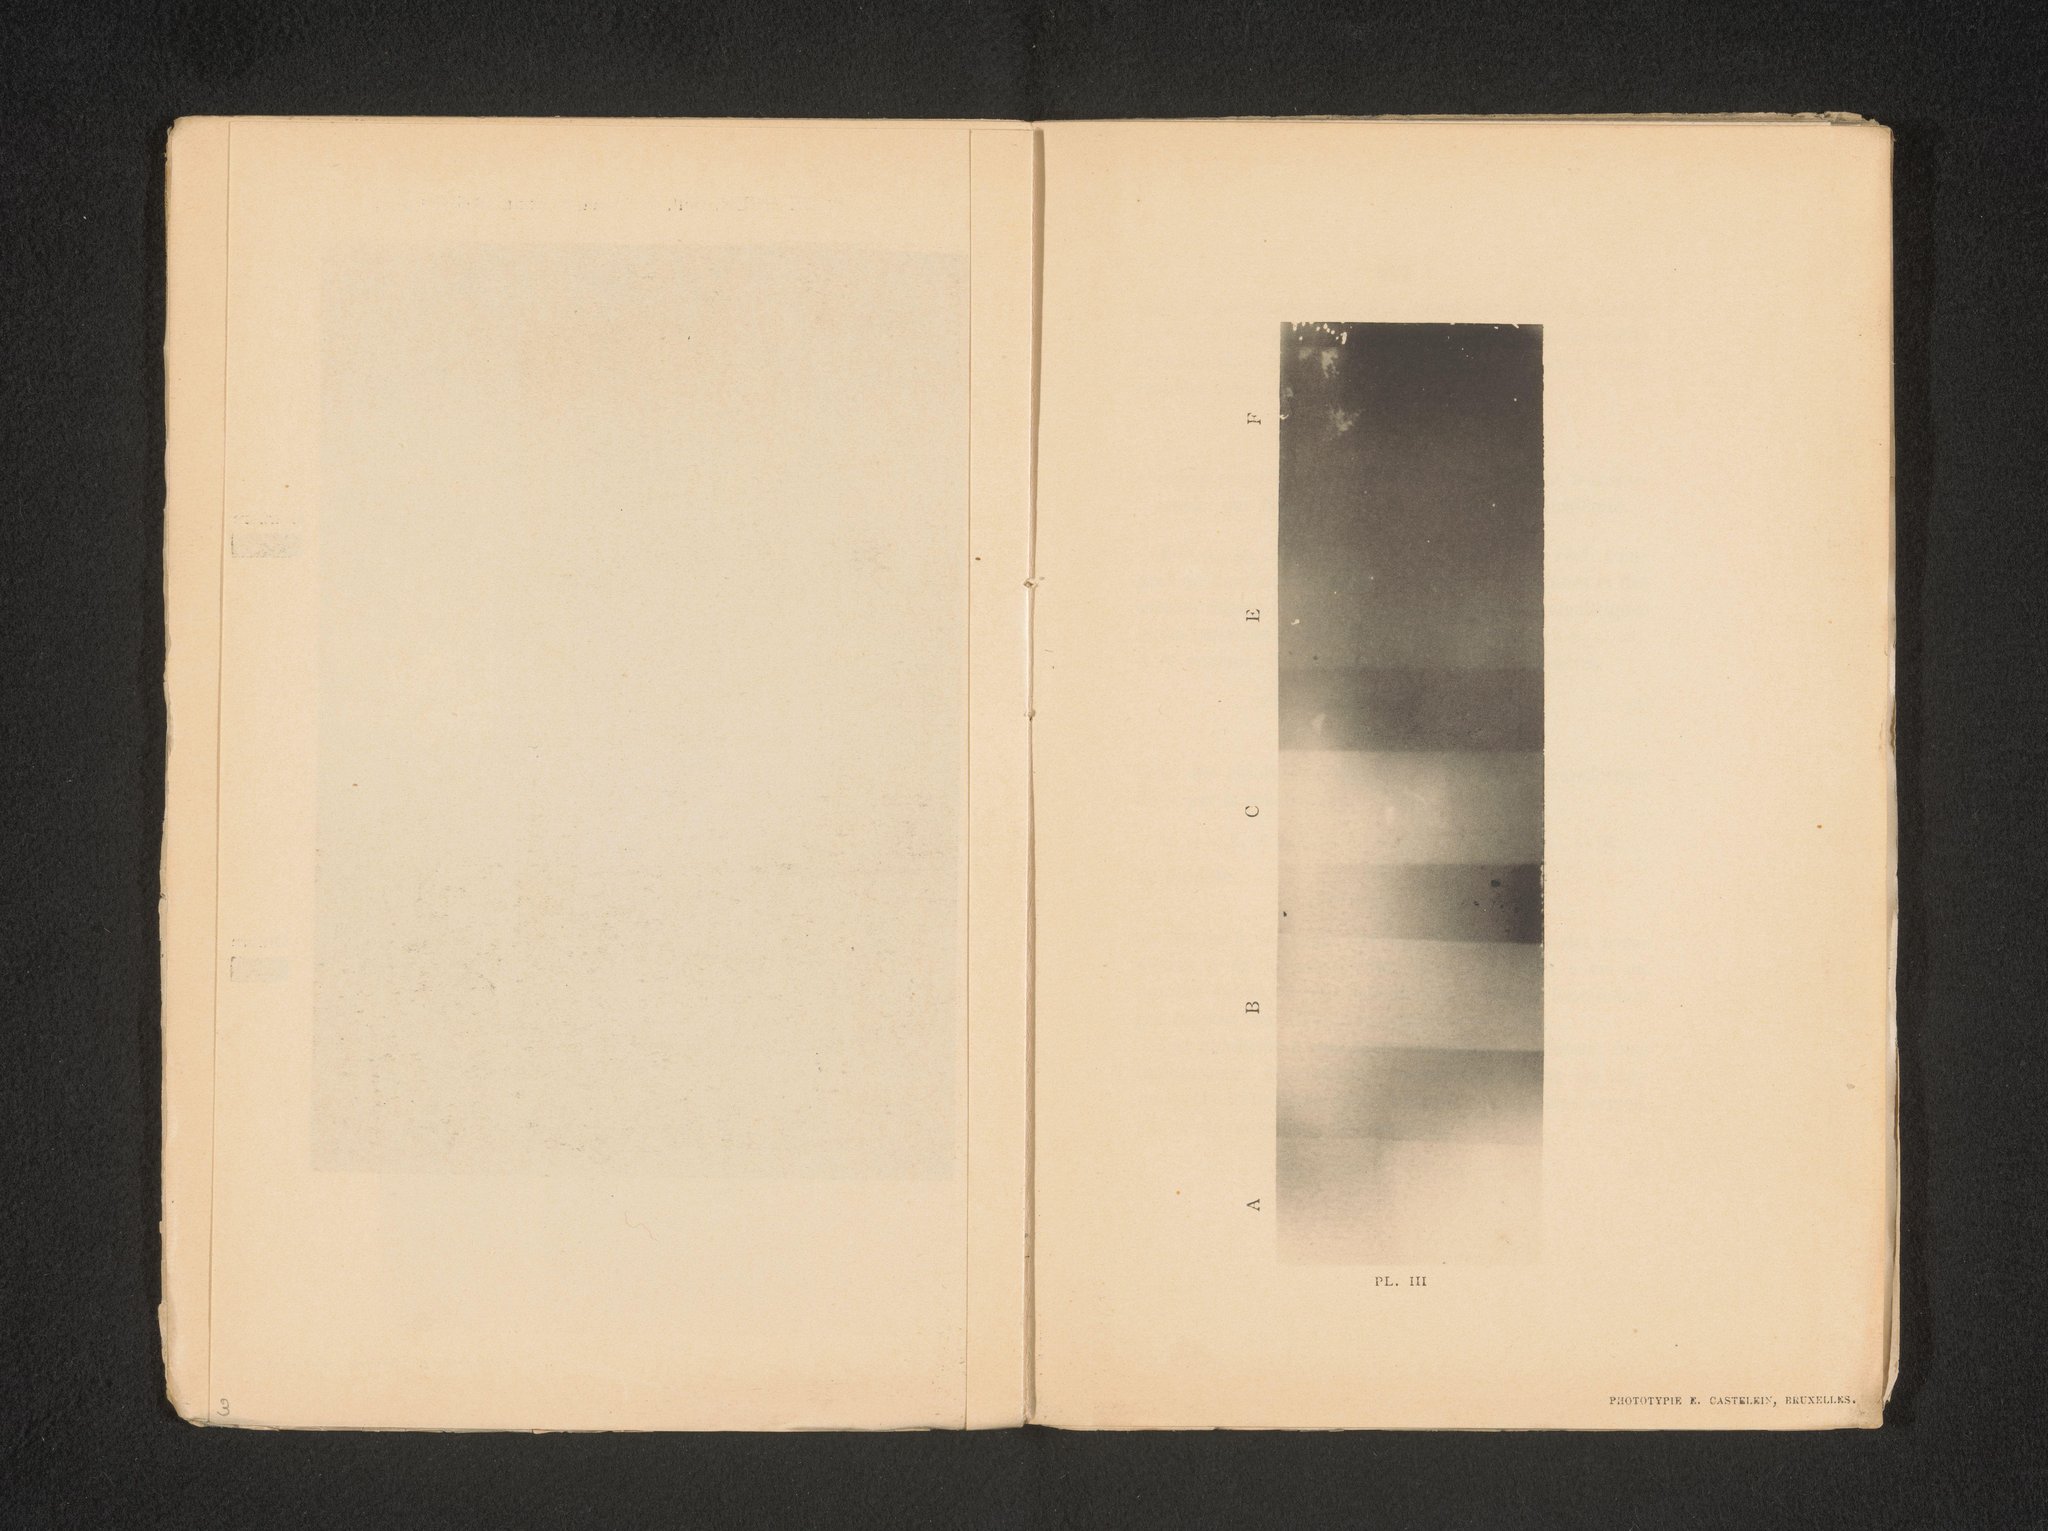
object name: photomechanical print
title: Voorbeeld van infra-elektrische energie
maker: e. castelein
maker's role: printer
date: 1891-1896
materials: paper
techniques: photograph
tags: electrical phenomena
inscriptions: inscription: ‘A B C E F’, inscription: ‘Pl. III’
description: Prent op vijfde ongenummerde pagina na pagina 432.